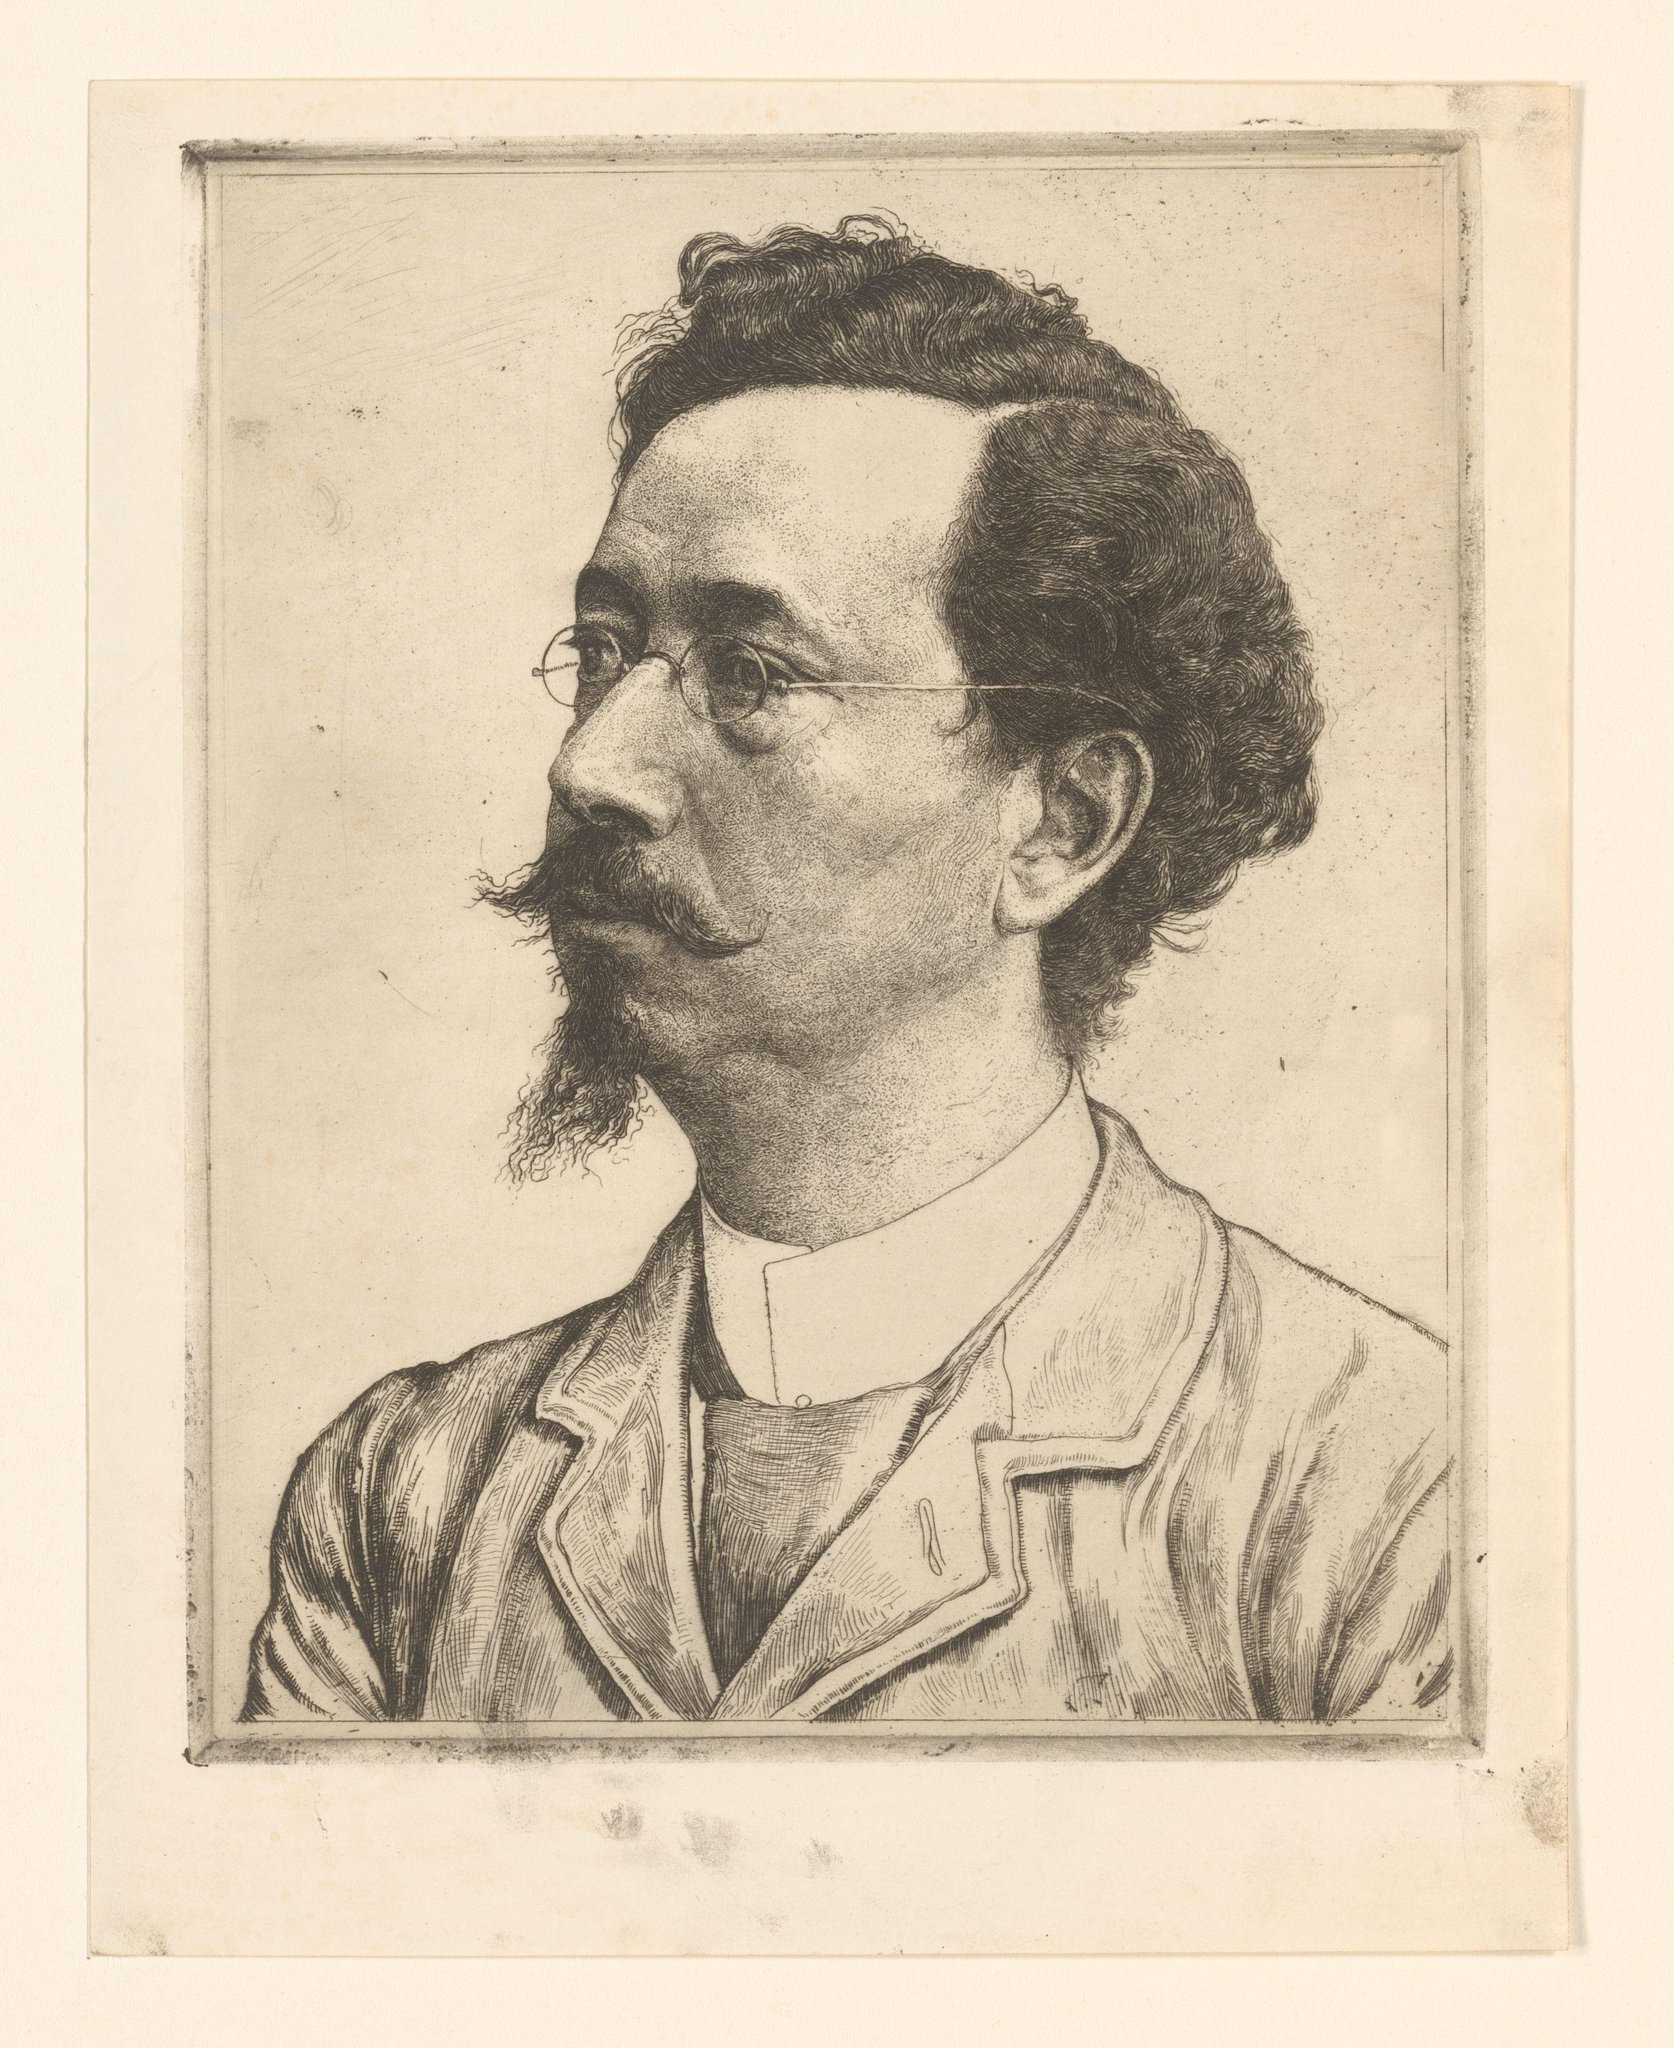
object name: print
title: Portret van Nicolaas de Roever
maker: jan veth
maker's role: designer, draughtsman, painter, print maker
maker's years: 1864-1925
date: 1893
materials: paper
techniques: drypoint, etching, intaglio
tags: historical persons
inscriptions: collector's mark: Lugt 2228